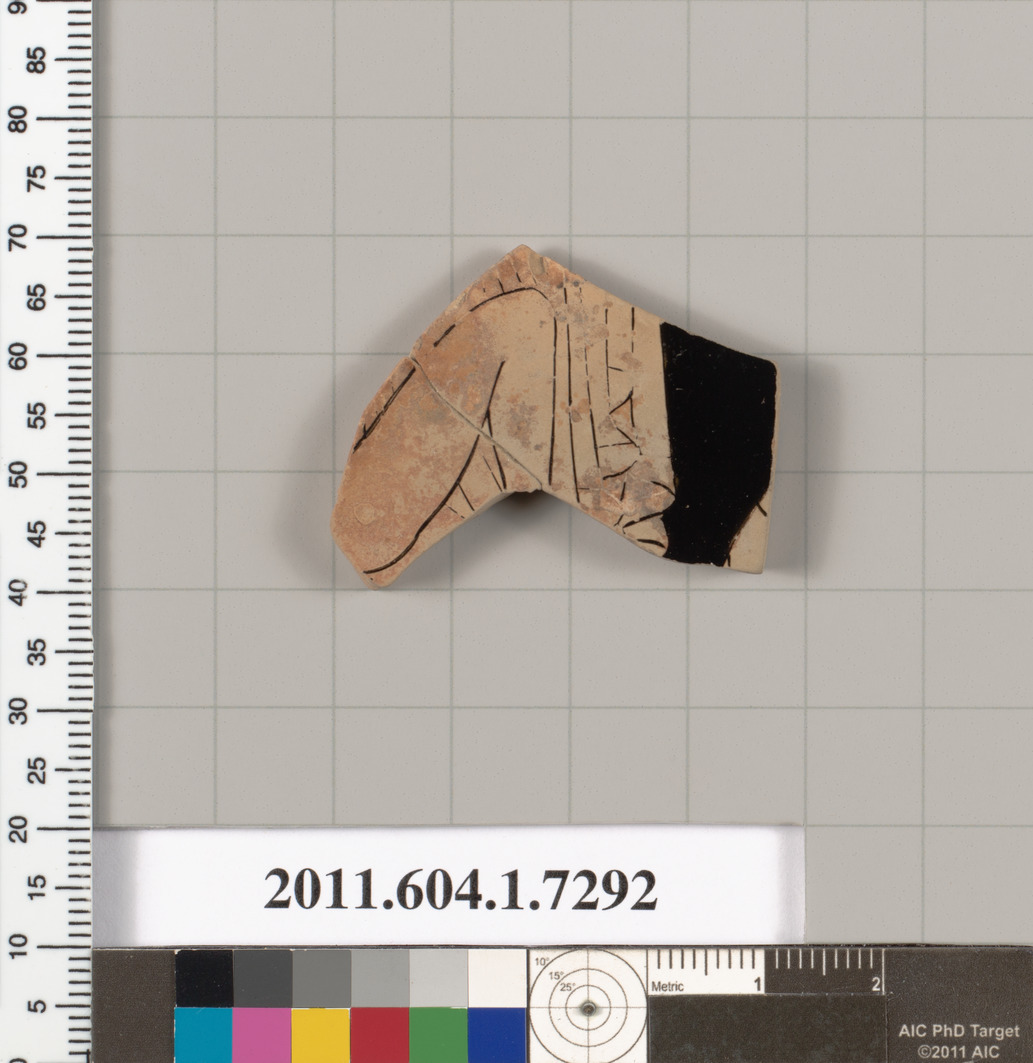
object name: kylix fragment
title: Terracotta fragment of a kylix (drinking cup)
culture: greek, attic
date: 500-480 BCE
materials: terracotta